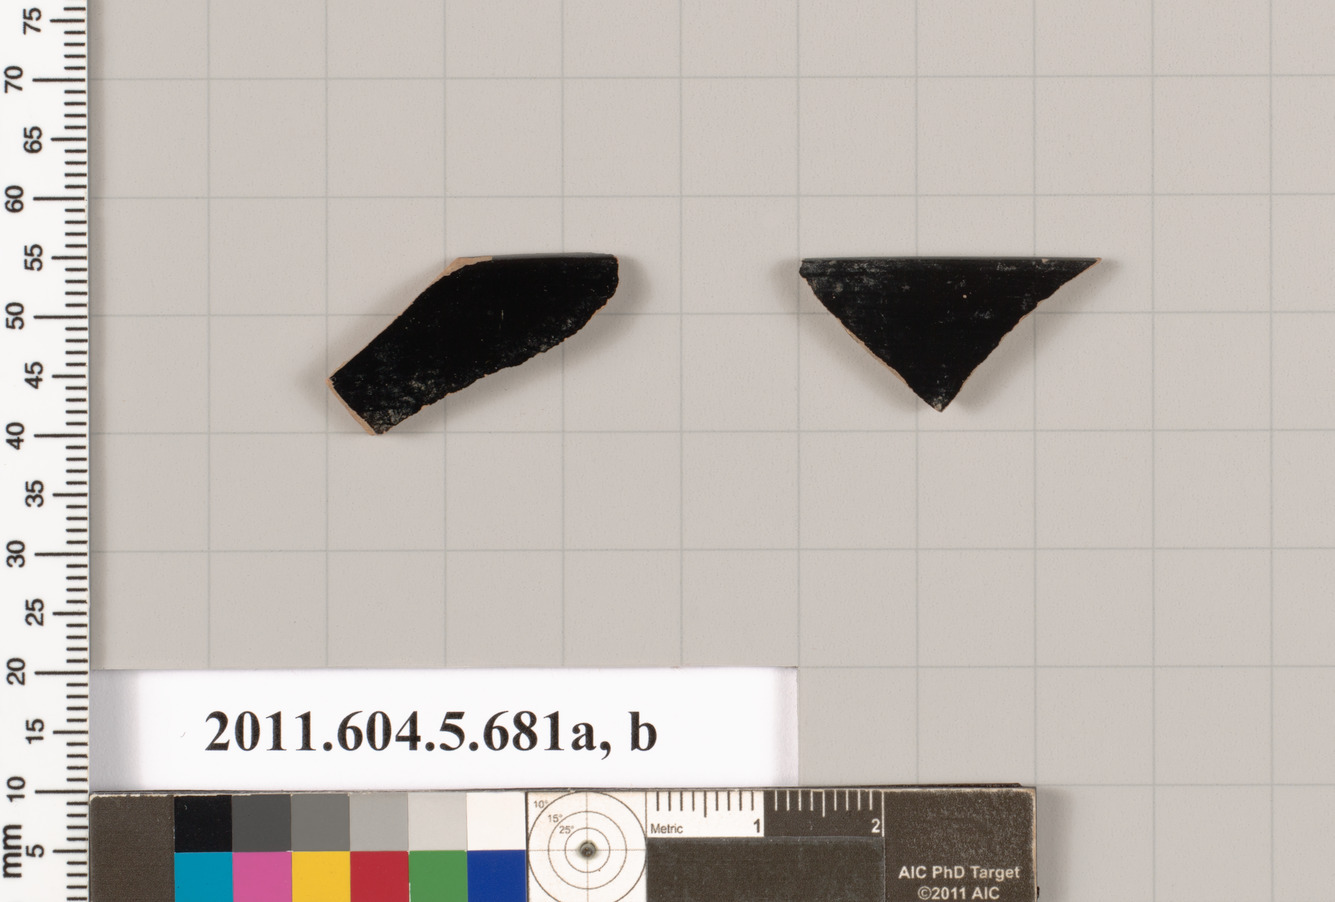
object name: kylix fragment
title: Terracotta rim fragments of kylikes (drinking cups)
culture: greek, attic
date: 600-401 BCE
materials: terracotta